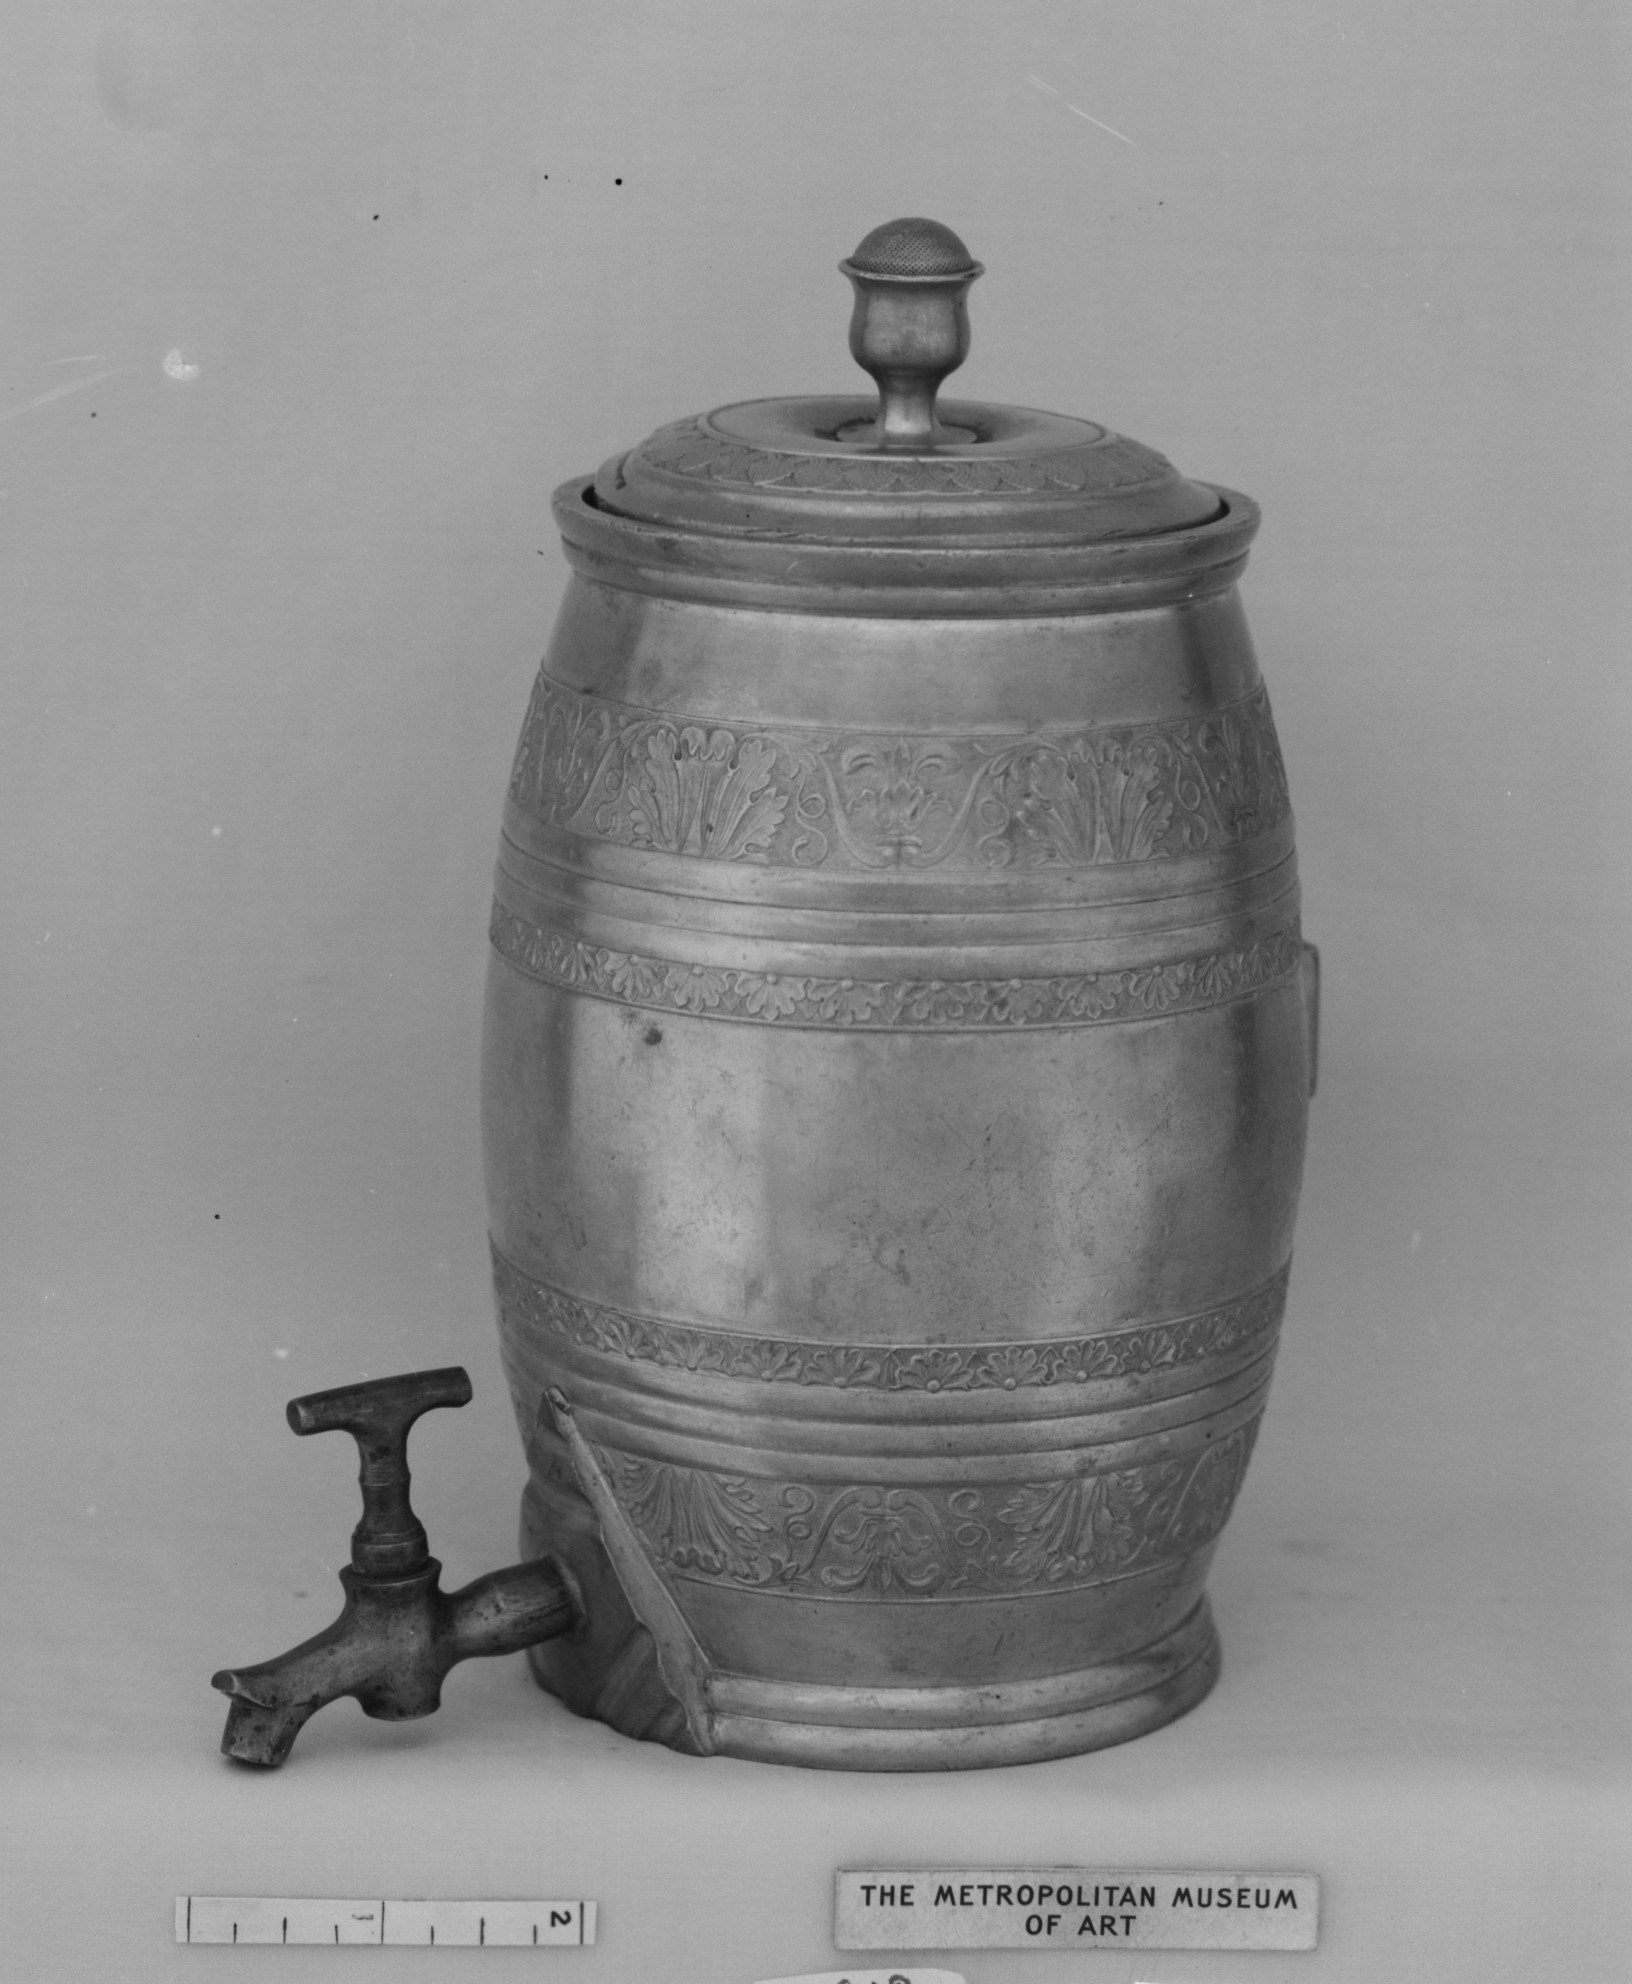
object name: lavatory or portable cistern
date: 1701-1800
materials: pewter